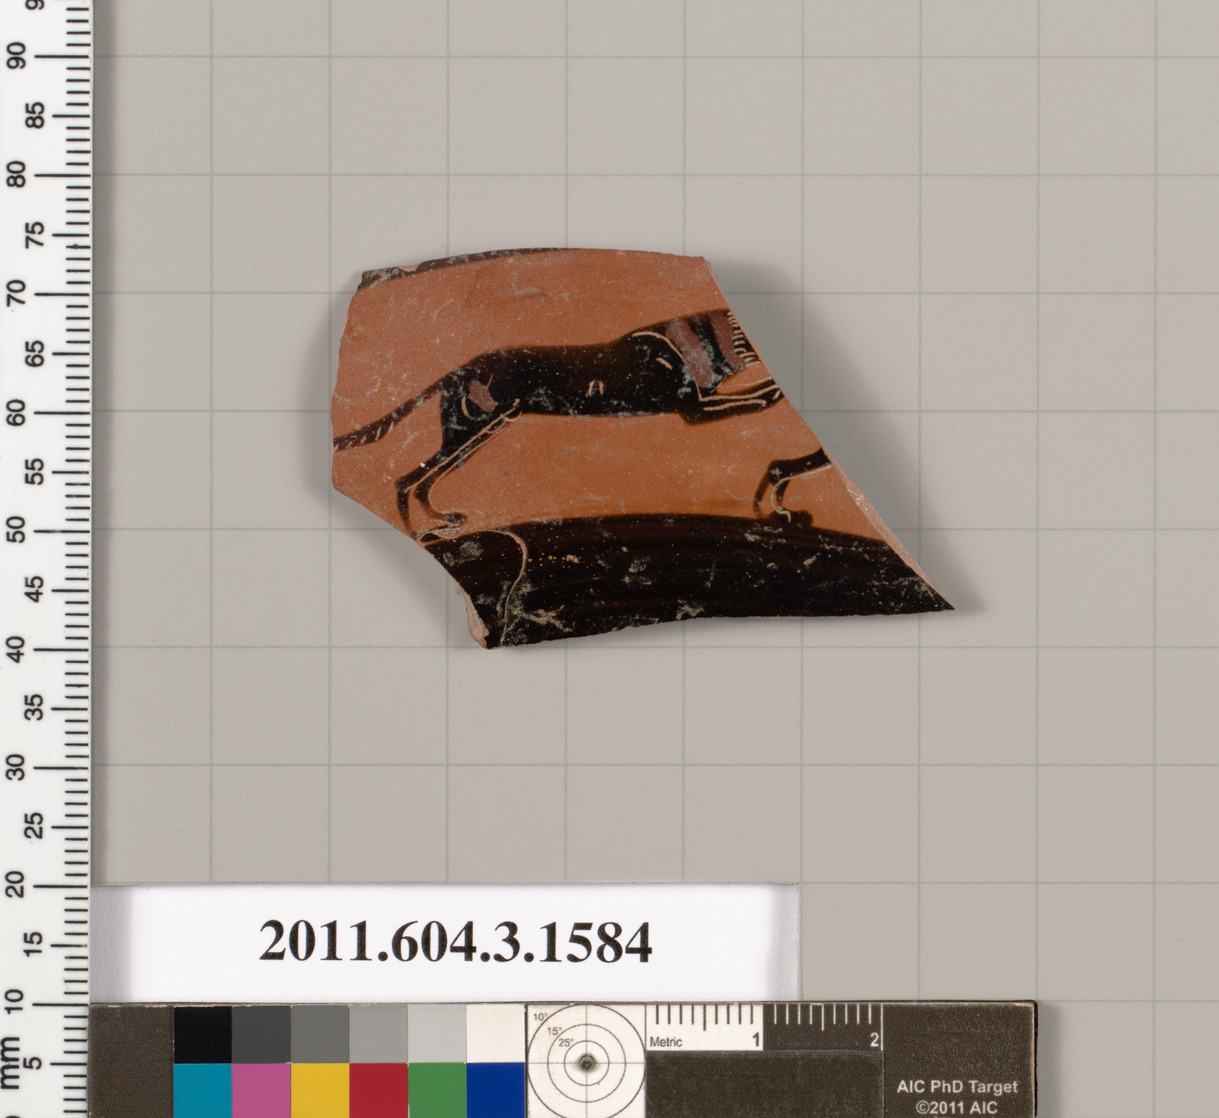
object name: kylix fragment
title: Terracotta fragment of a kylix: Band cup (drinking cup)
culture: greek, attic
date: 550-526 BCE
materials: terracotta